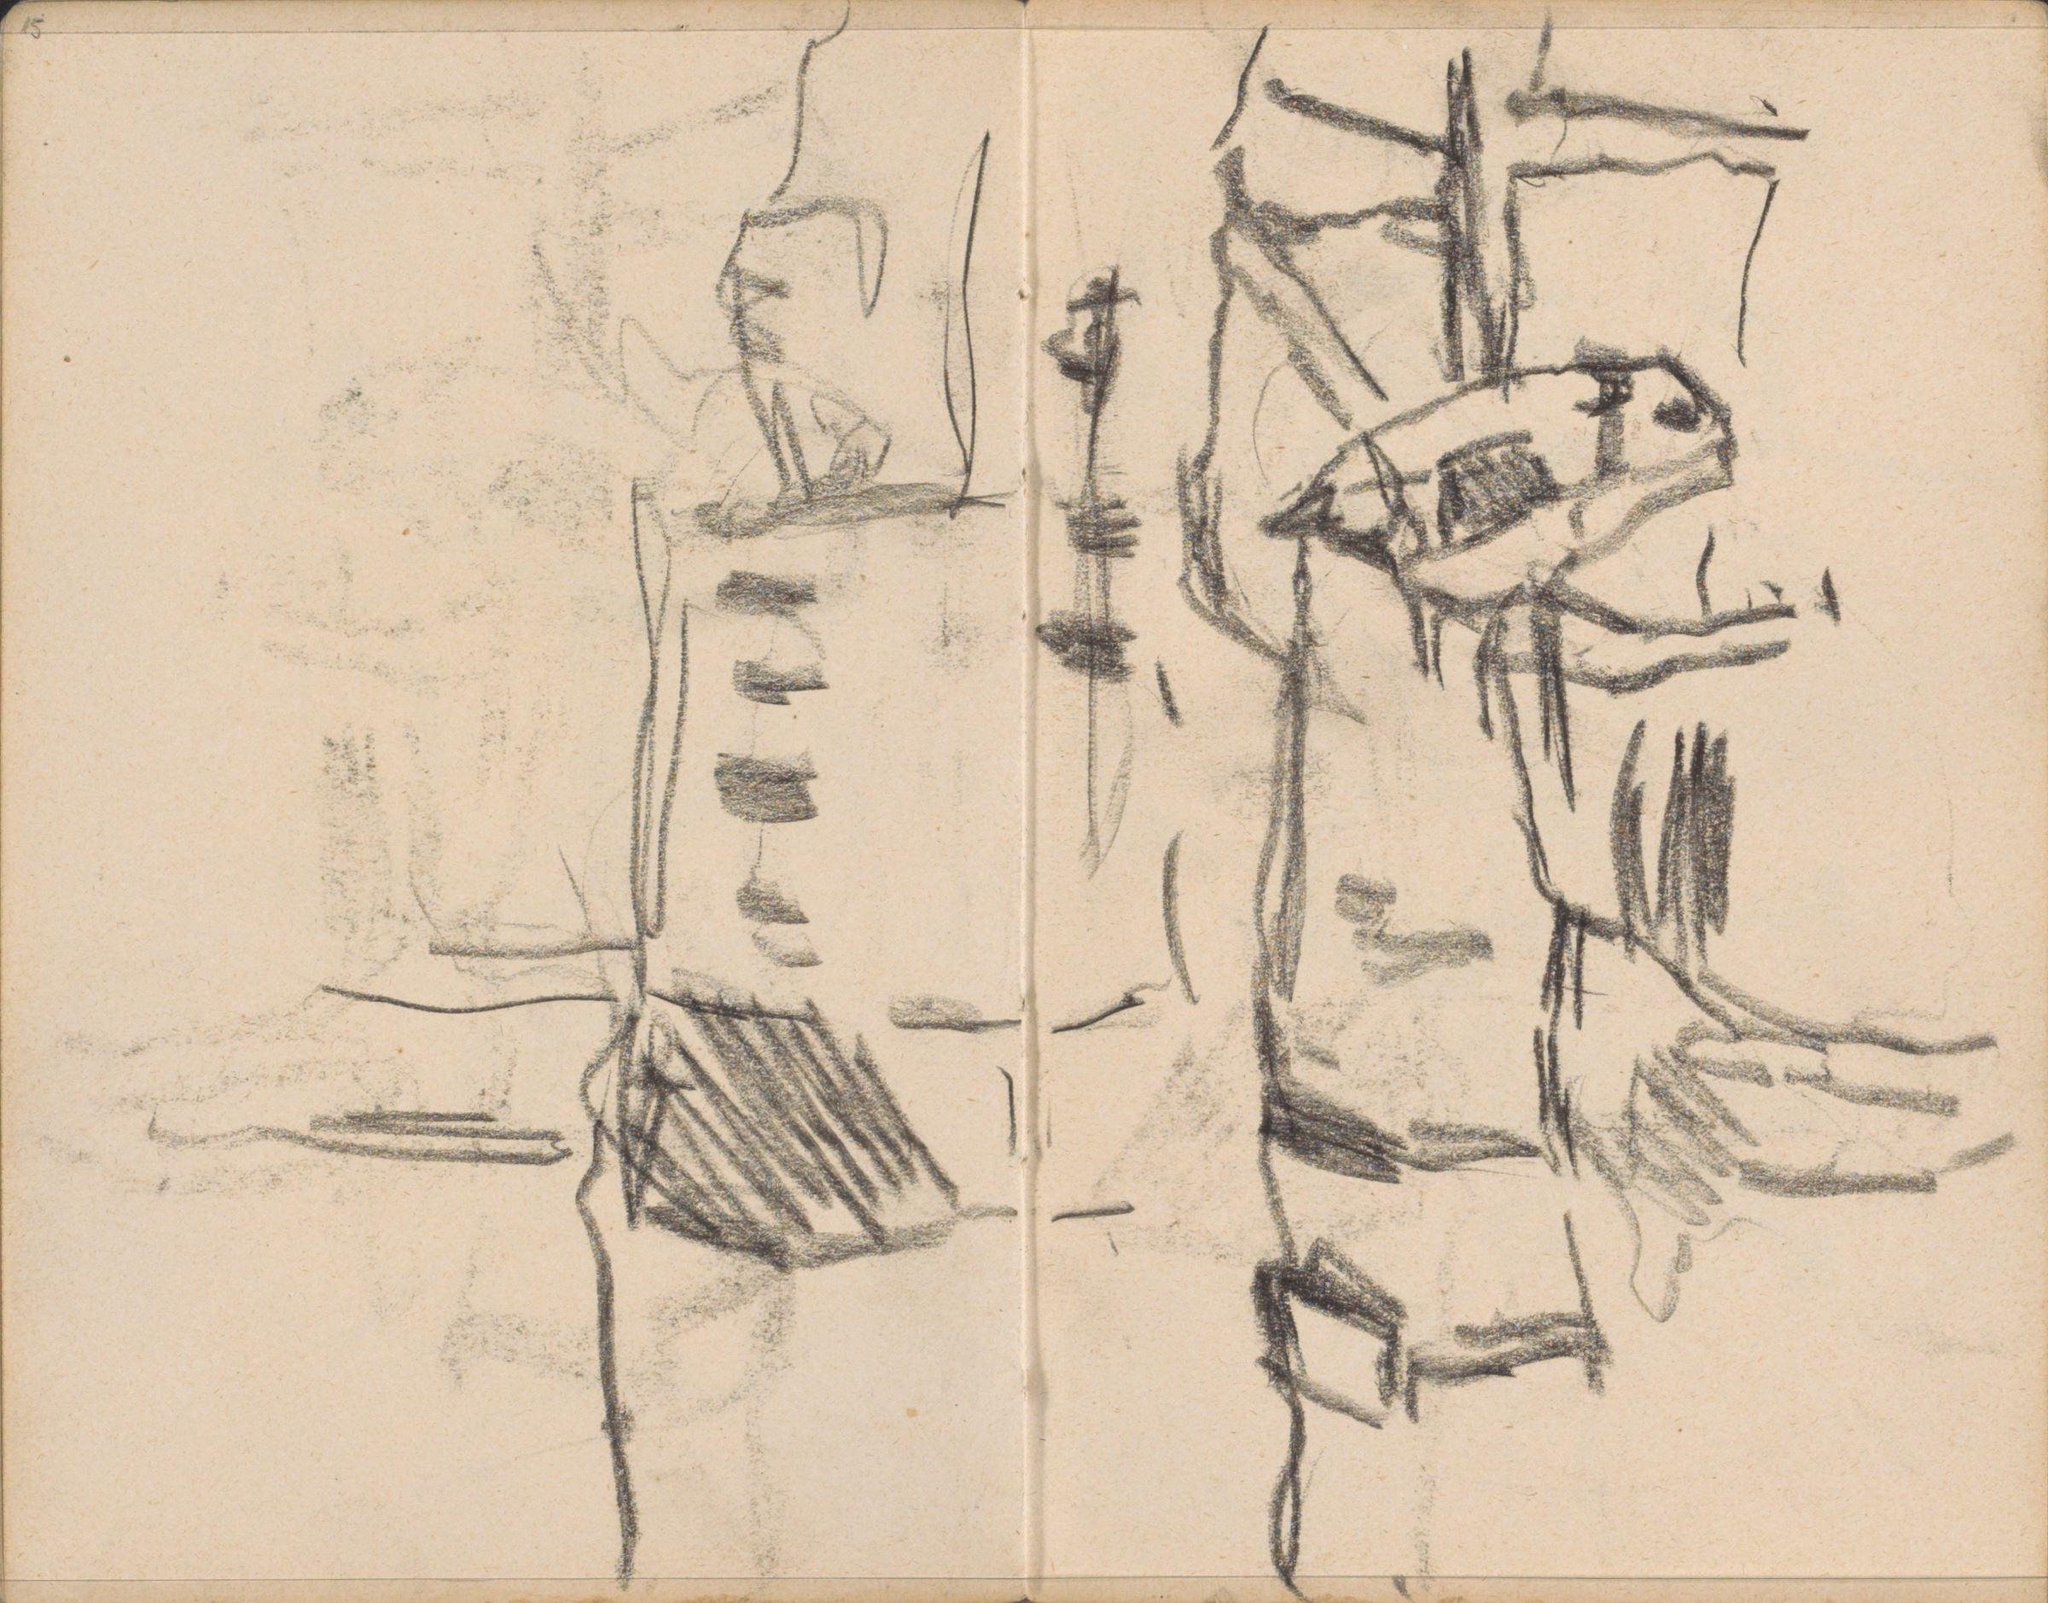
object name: sketchbook leaf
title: Aangespannen paarden, mogelijk op de Dam in Amsterdam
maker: george hendrik breitner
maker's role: draughtsman, painter, print maker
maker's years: 1857-1923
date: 1909-1912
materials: chalk, paper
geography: amsterdam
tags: four-wheeled vehicle drawn by one animal, urban housing, horse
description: Aangespannen paarden met oogkleppen, mogelijk op de Dam in Amsterdam. Pagina 15 en pagina 16 uit een schetsboek met 46 bladen vervaardigd te Amsterdam.